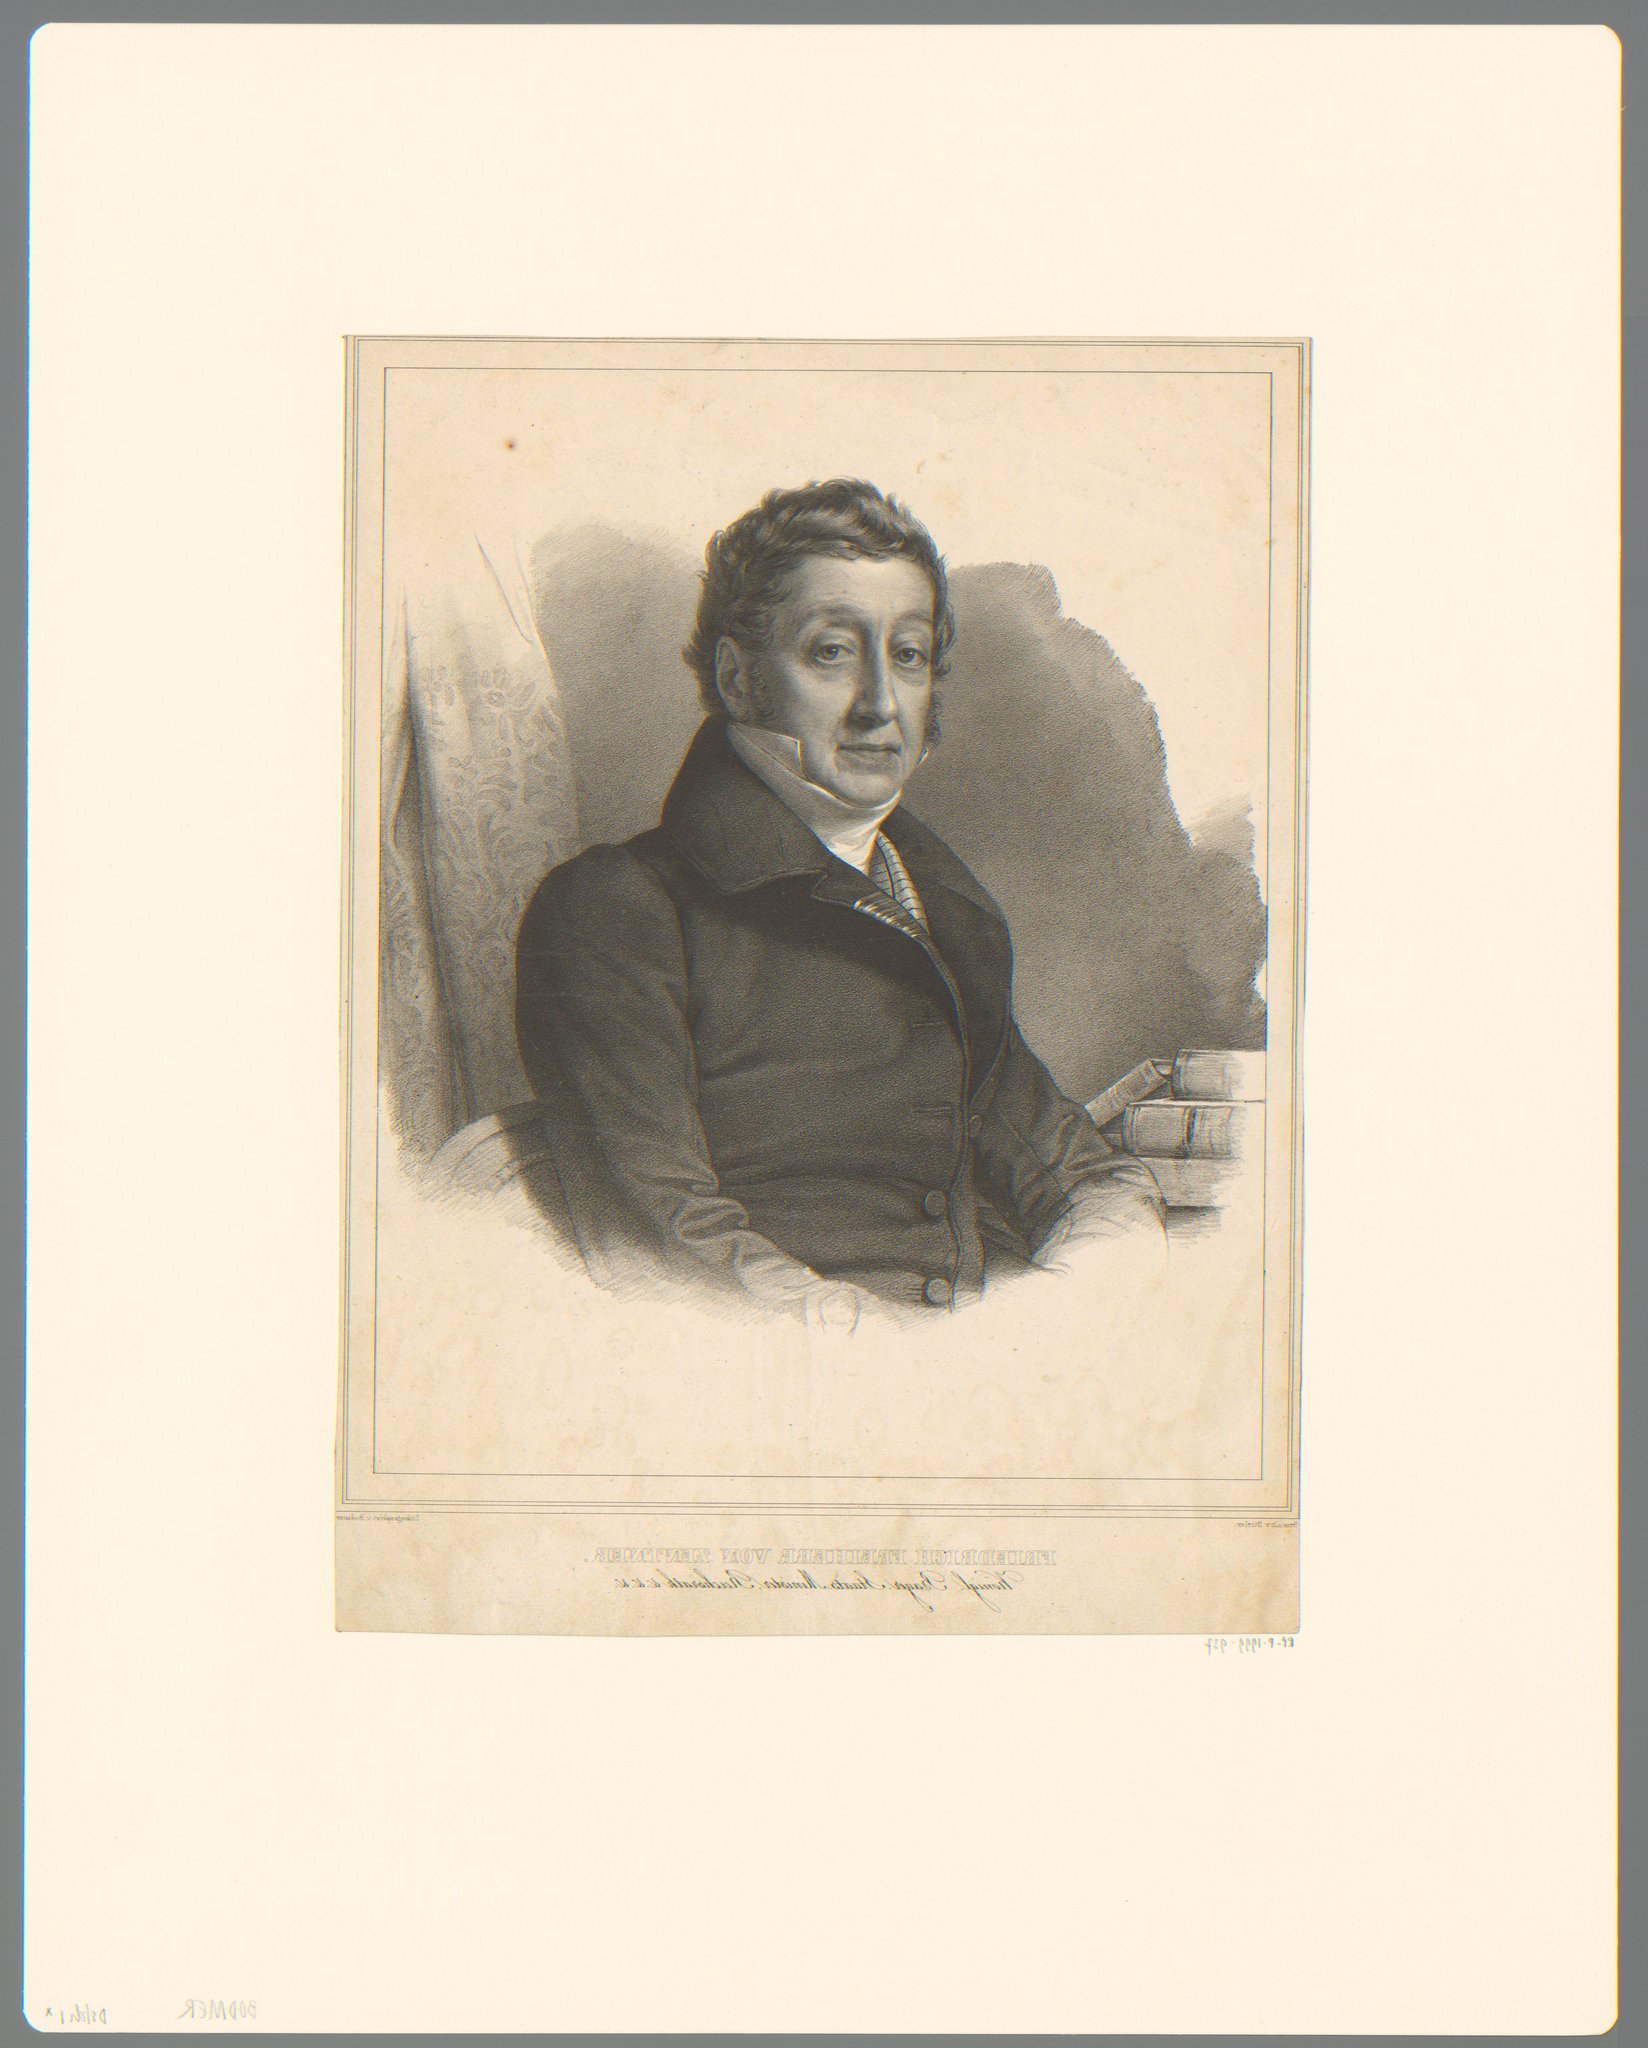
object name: print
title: Friedrich Freiherr von Zentner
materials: paper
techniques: lithograph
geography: germany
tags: adult man, historical persons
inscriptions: collector's mark: Lugt 2228, collector's mark: Lugt 2760, collector's mark